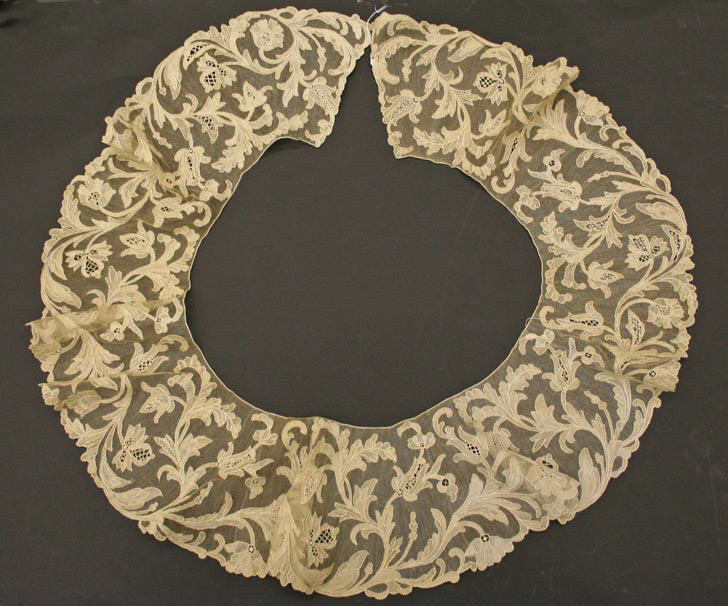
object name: bertha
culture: italian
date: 1867-1900